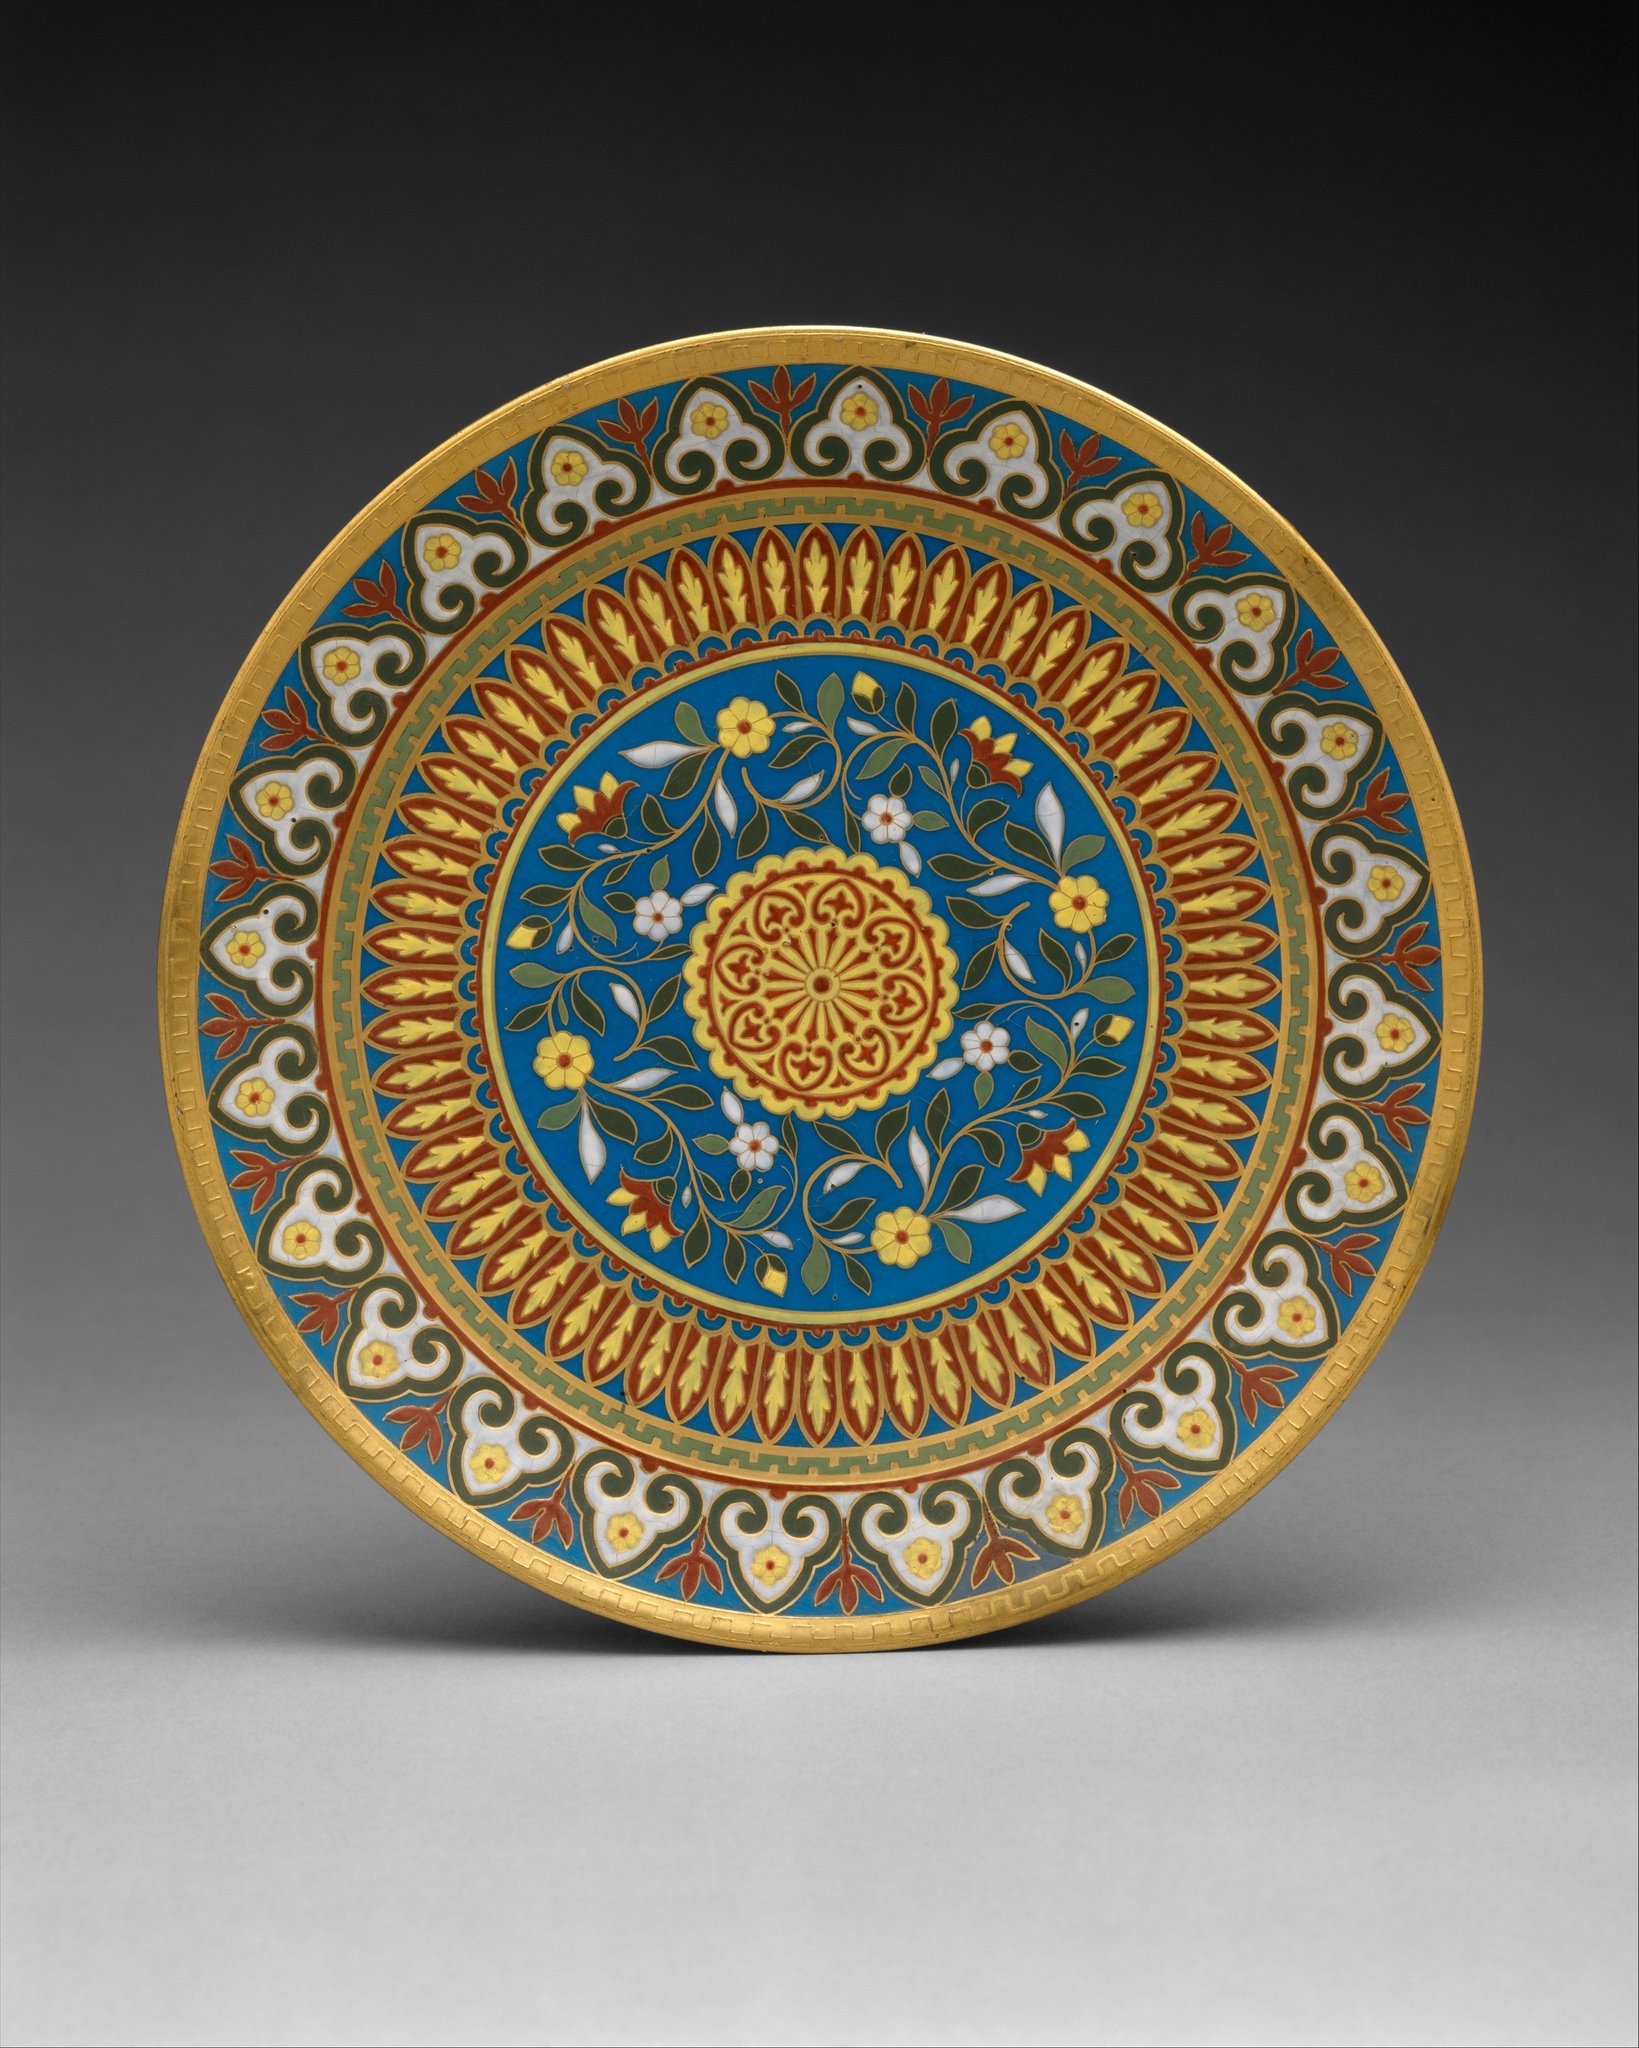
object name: plate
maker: minton(s)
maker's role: factory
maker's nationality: british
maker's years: 1793-2001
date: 1878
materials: bone china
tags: flowers